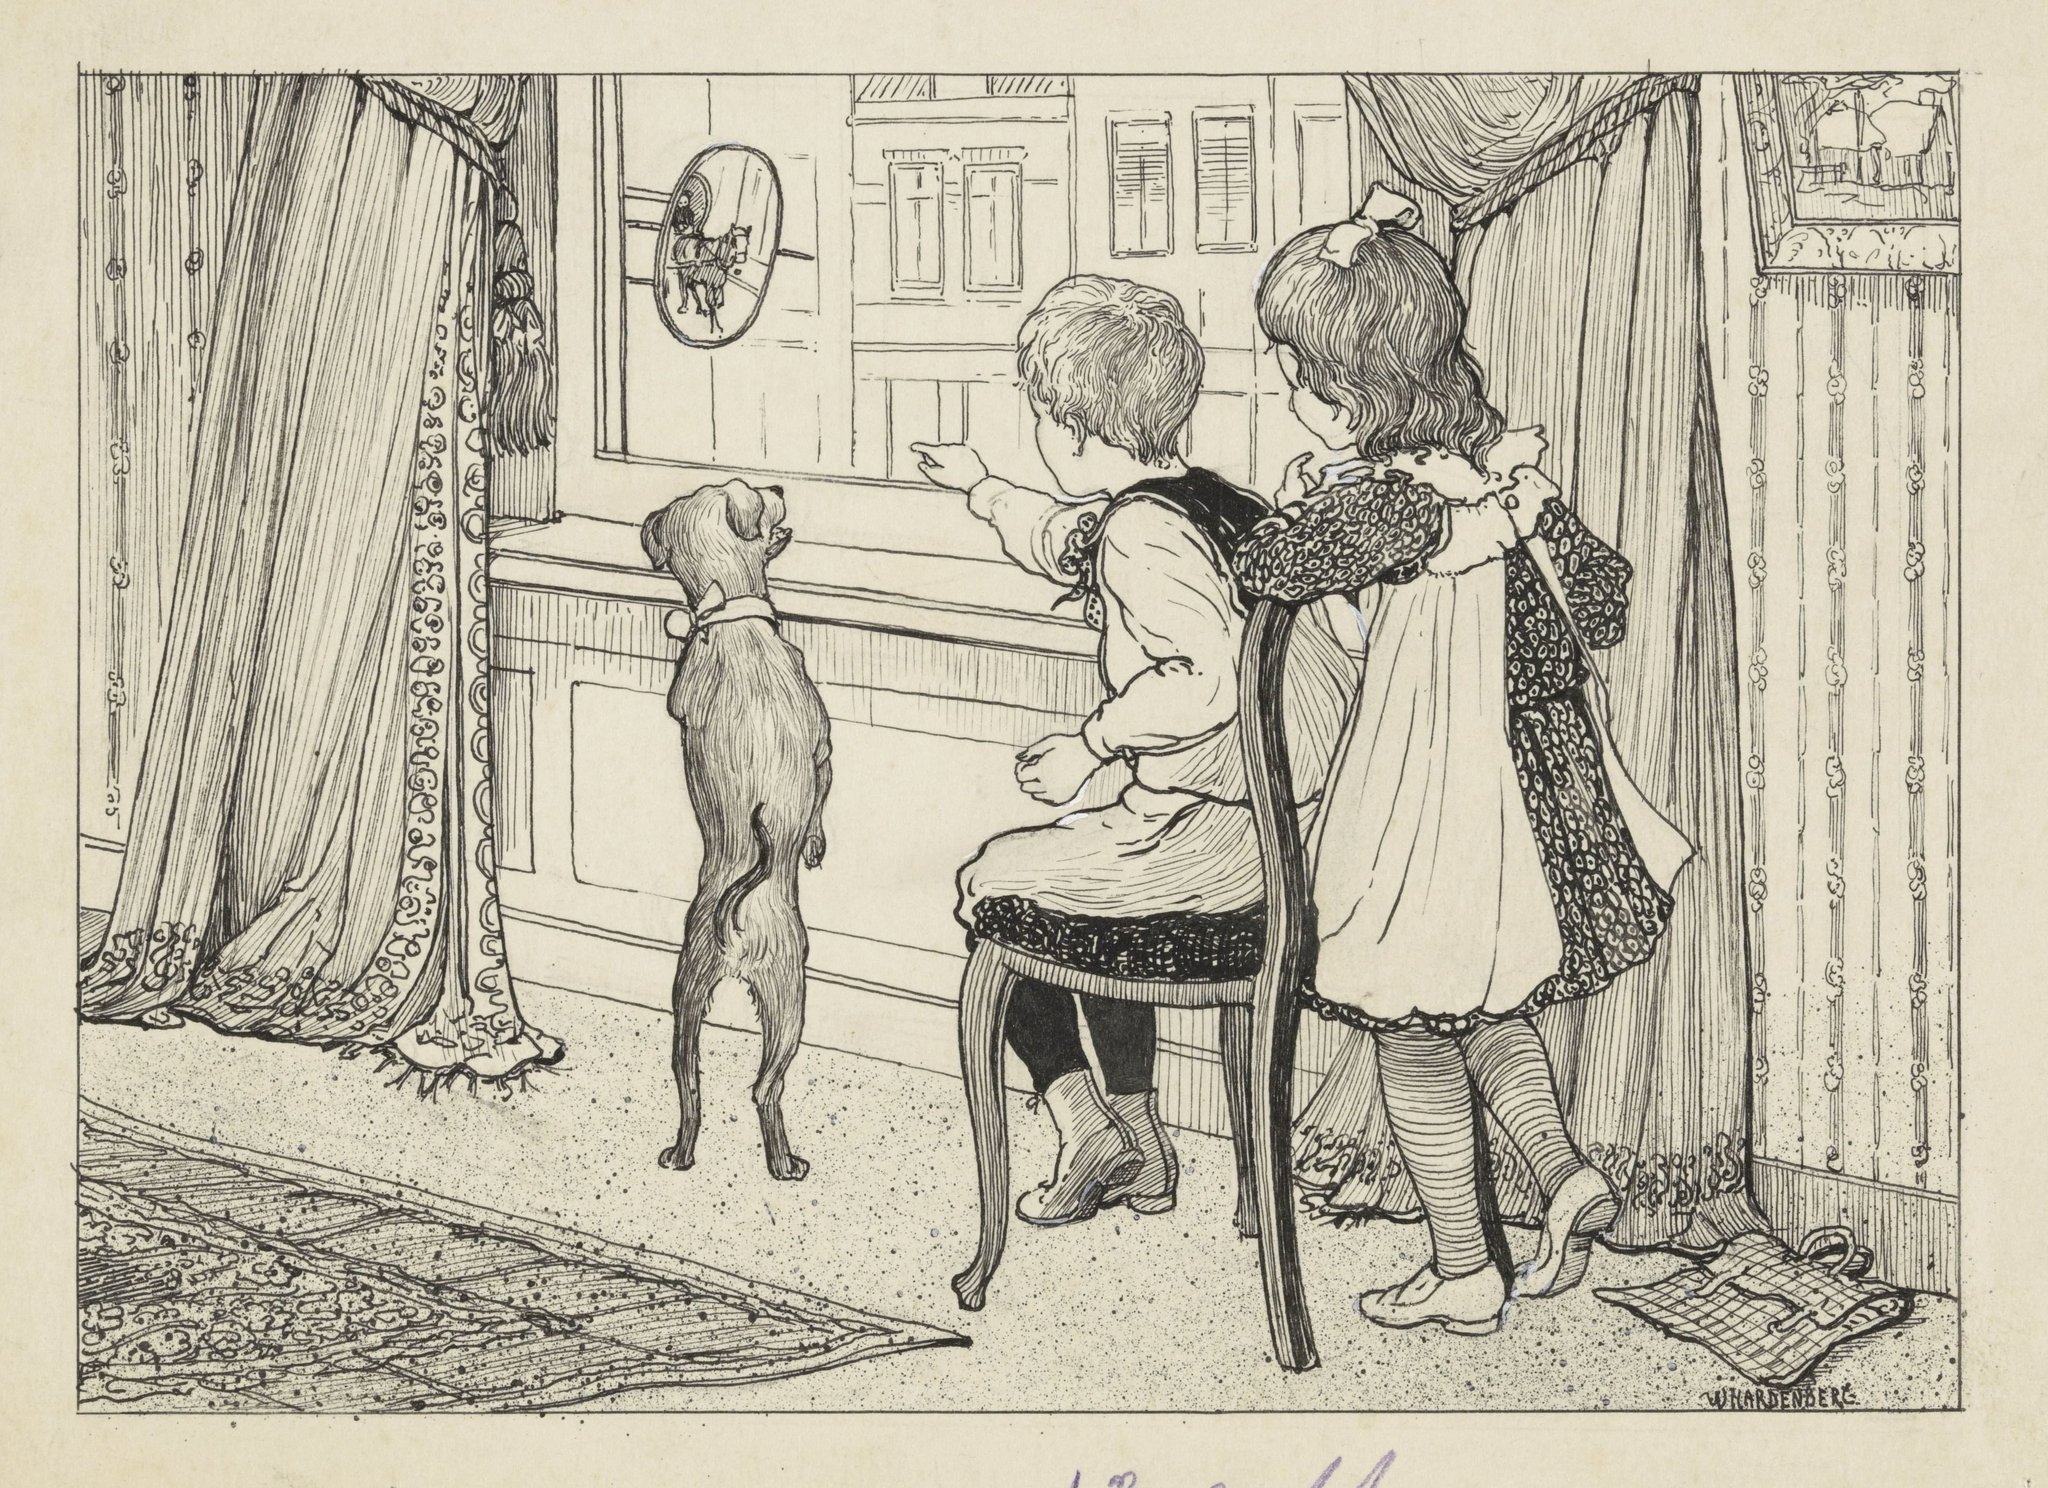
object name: drawing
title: Jongen, meisje en hond bij een venster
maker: willem hardenberg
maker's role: draughtsman, print maker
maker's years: 1879-1939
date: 1889-1939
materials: paint, ink, paper, pencil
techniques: brush, pen, spatter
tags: mirror, child, interior of the house, dog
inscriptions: signature: ‘WHARDENBERG’, collector's mark: Lugt 2228, :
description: In een interieur zit een jongen op een stoel bij een venster. Een hond staat naast hem en een meisje staat achter de stoel. De jongen wijst naar een spiegel aan de buitenzijde van de gevel, waarin een paardenkoets op straat weerspiegeld is.